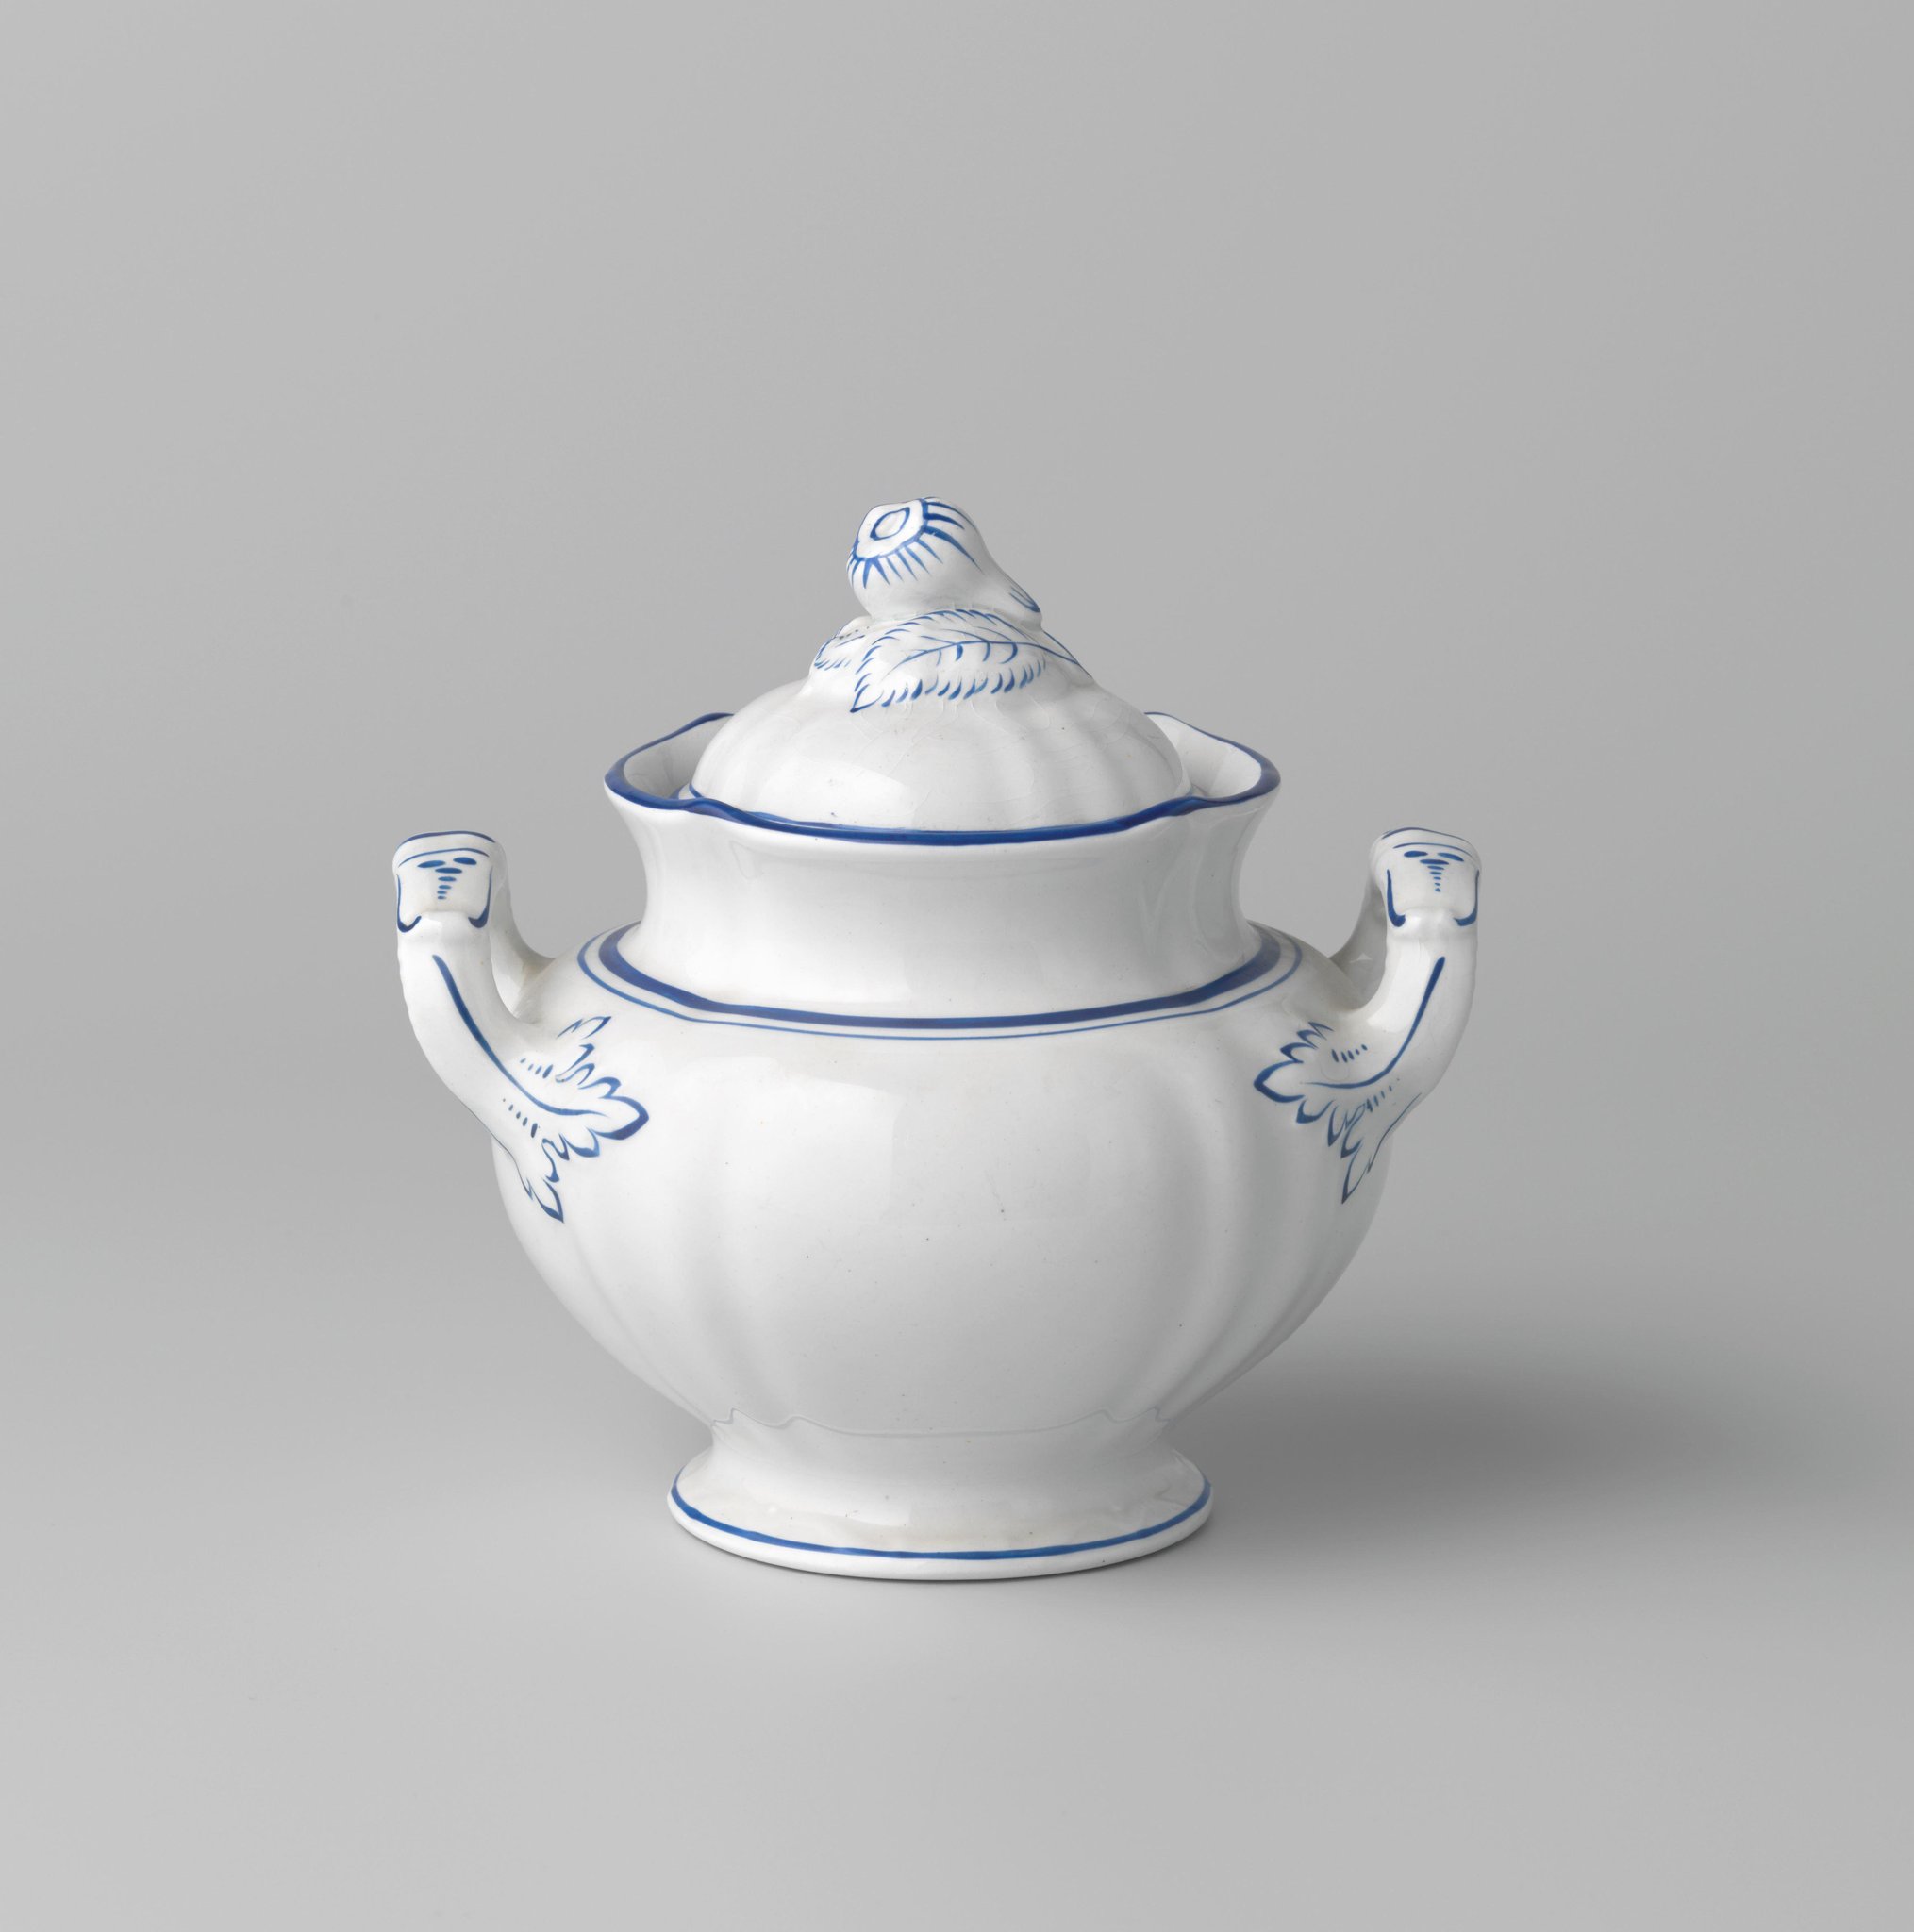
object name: sugar box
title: Suikerpot wit, met blauwe biezen en peervormige dekselknop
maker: petrus regout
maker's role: plateelbakker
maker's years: 1801-1879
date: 1860-1890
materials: creamware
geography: maastricht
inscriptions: check stamp: ‘P. REGOUT // MAASTRICHT // 13 X’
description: Suikerpot van aardewerk, behorend bij een koffie- en theeservies, wit, met blauwe biezen.